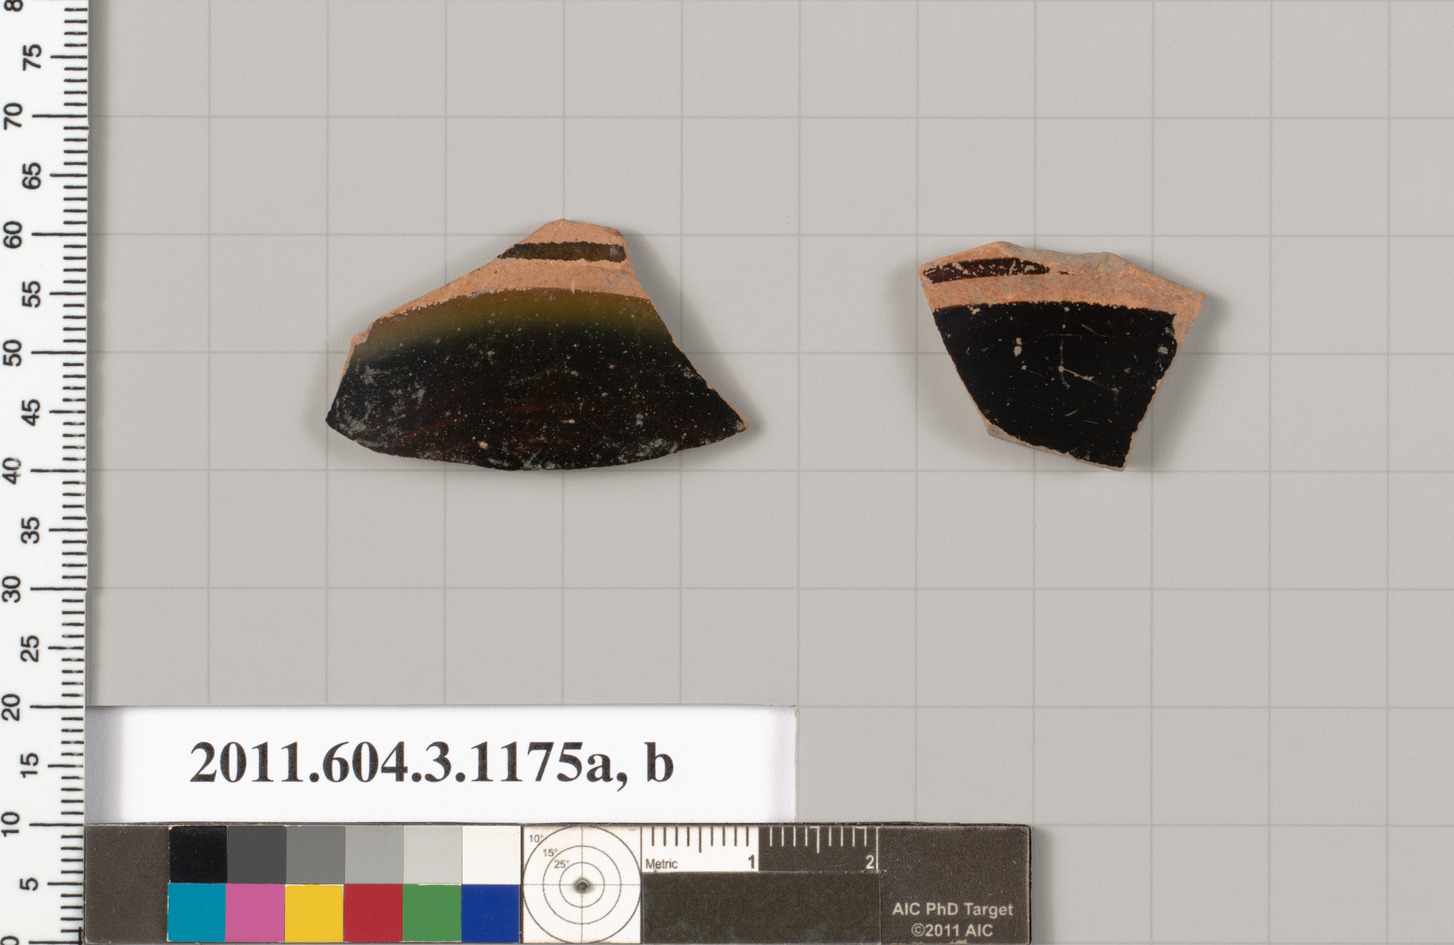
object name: mastoid or kyathos fragment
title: Terracotta fragments of mastoids (drinking cups with narrow base) or kyathoi (cup-shaped ladles)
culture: greek, attic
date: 534-468 BCE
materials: terracotta